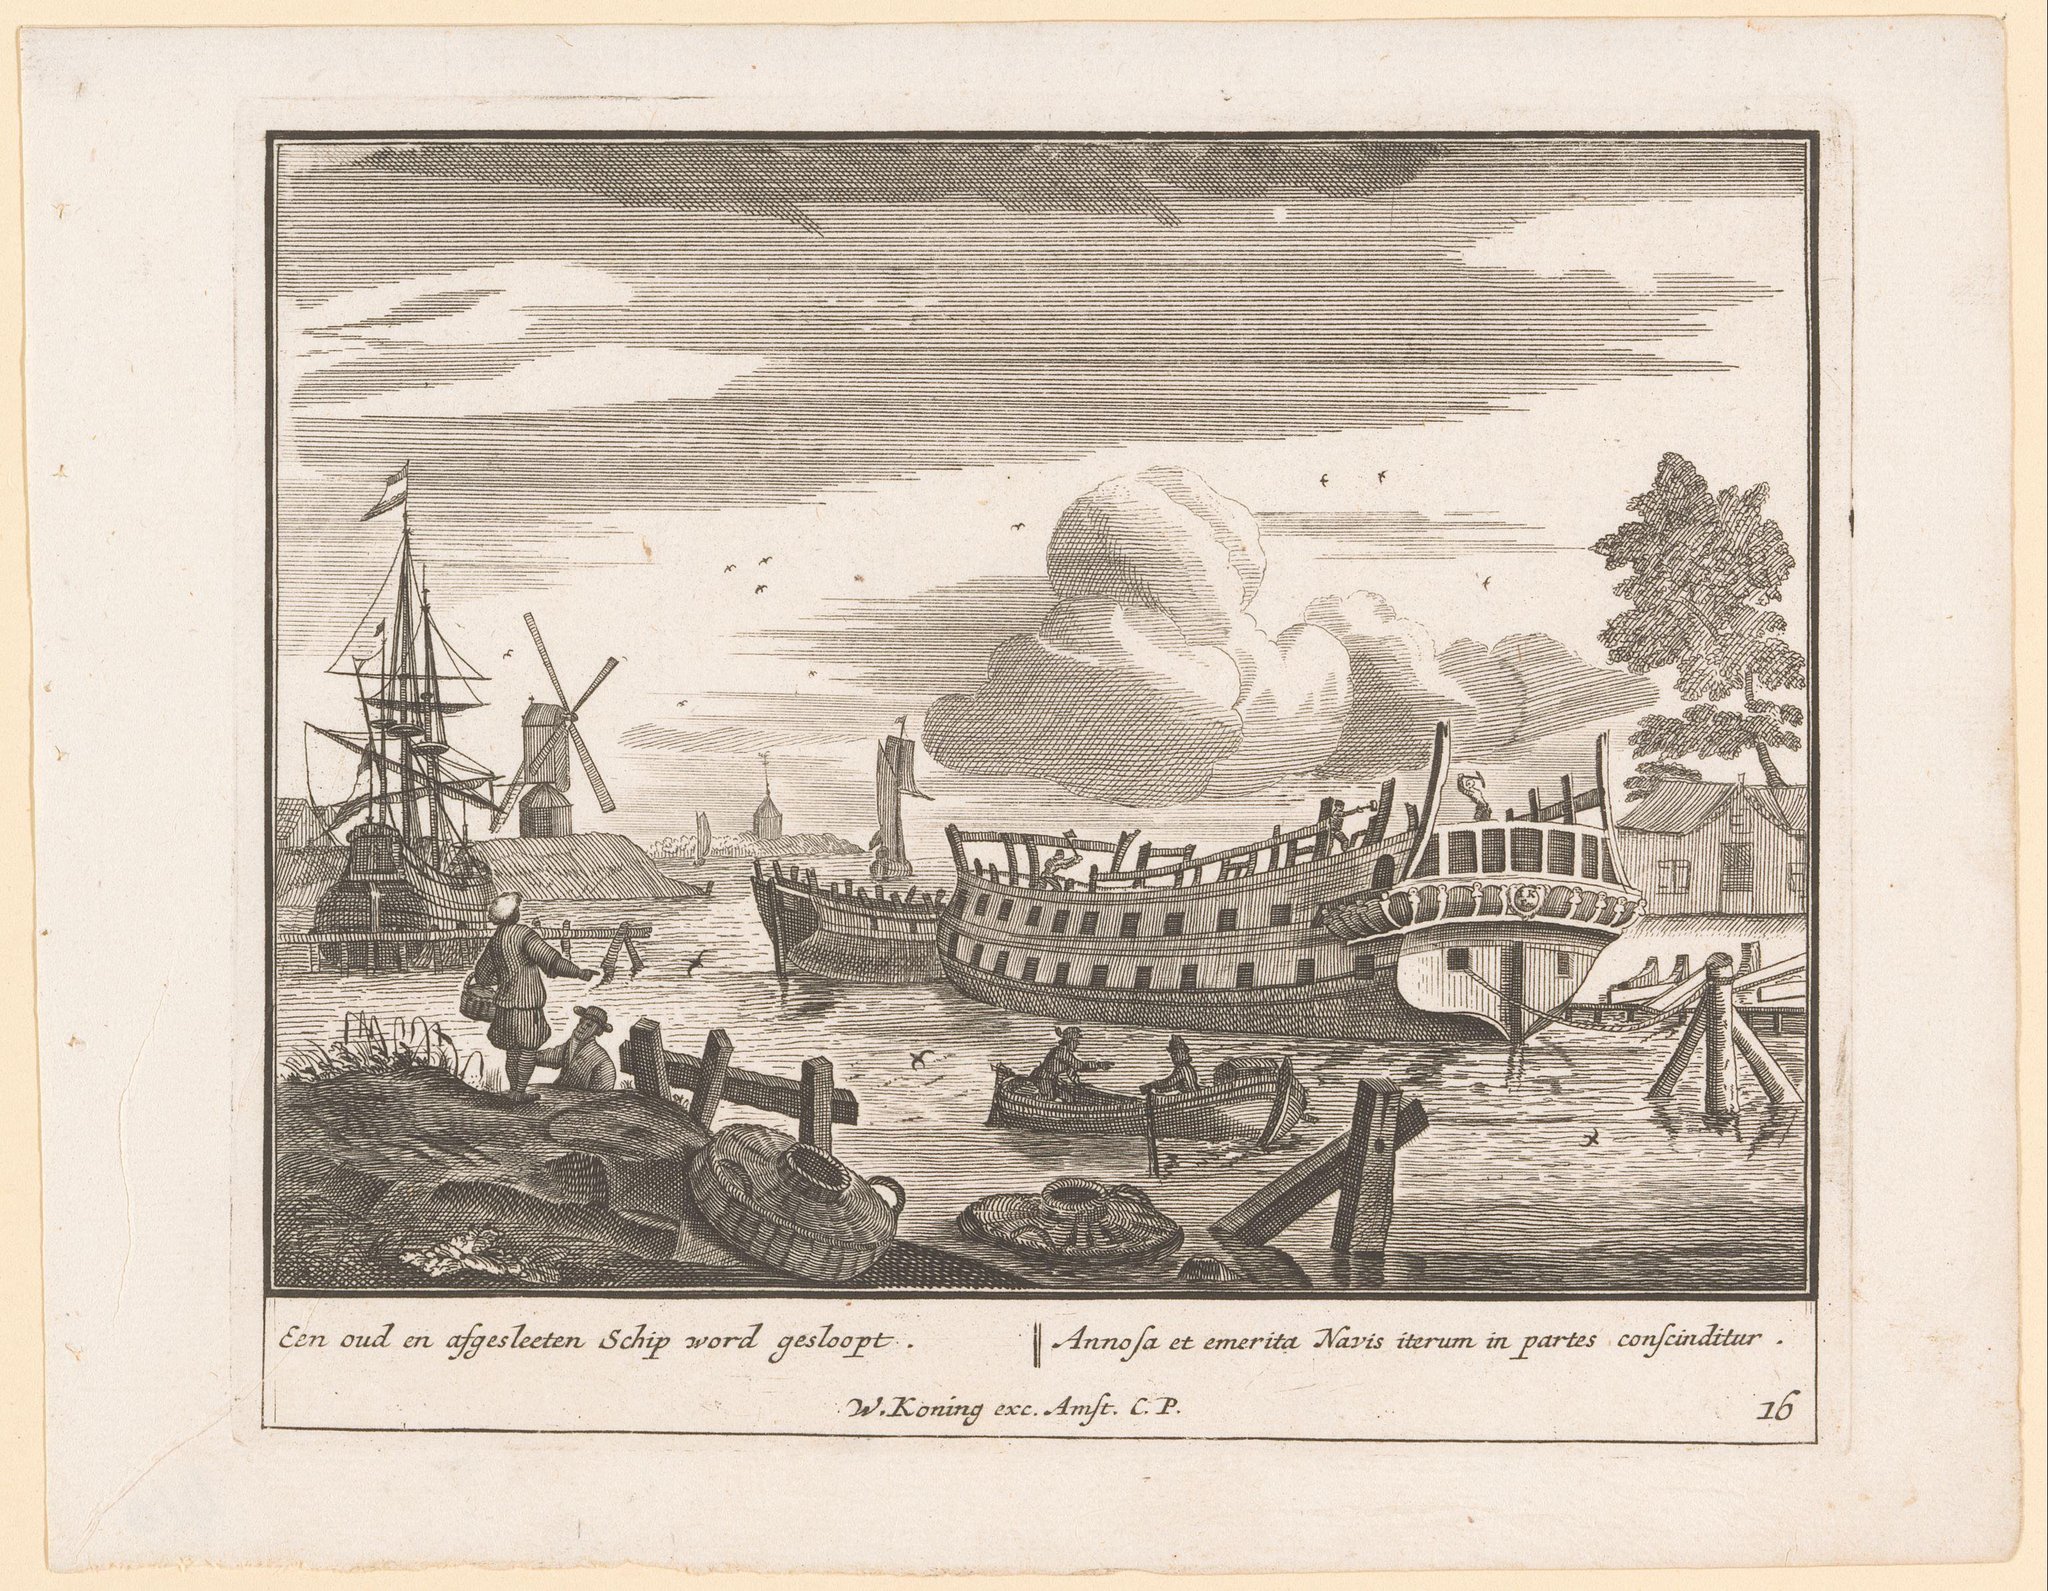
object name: print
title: Schepen in aanbouw en enkele ongelukken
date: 1717-1732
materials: paper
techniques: engraving, etching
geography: amsterdam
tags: shipyard, shipdock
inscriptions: collector's mark: Lugt 2228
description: Maakt deel uit van een zestiendelige serie met verschillende schepen in aanbouw en enkele ongelukken, getiteld 'Navigiorum Aedificatio' naar prenten door Siewert van der Meulen, uitgegeven door Isaac Greve en Wilhelmus Koning.